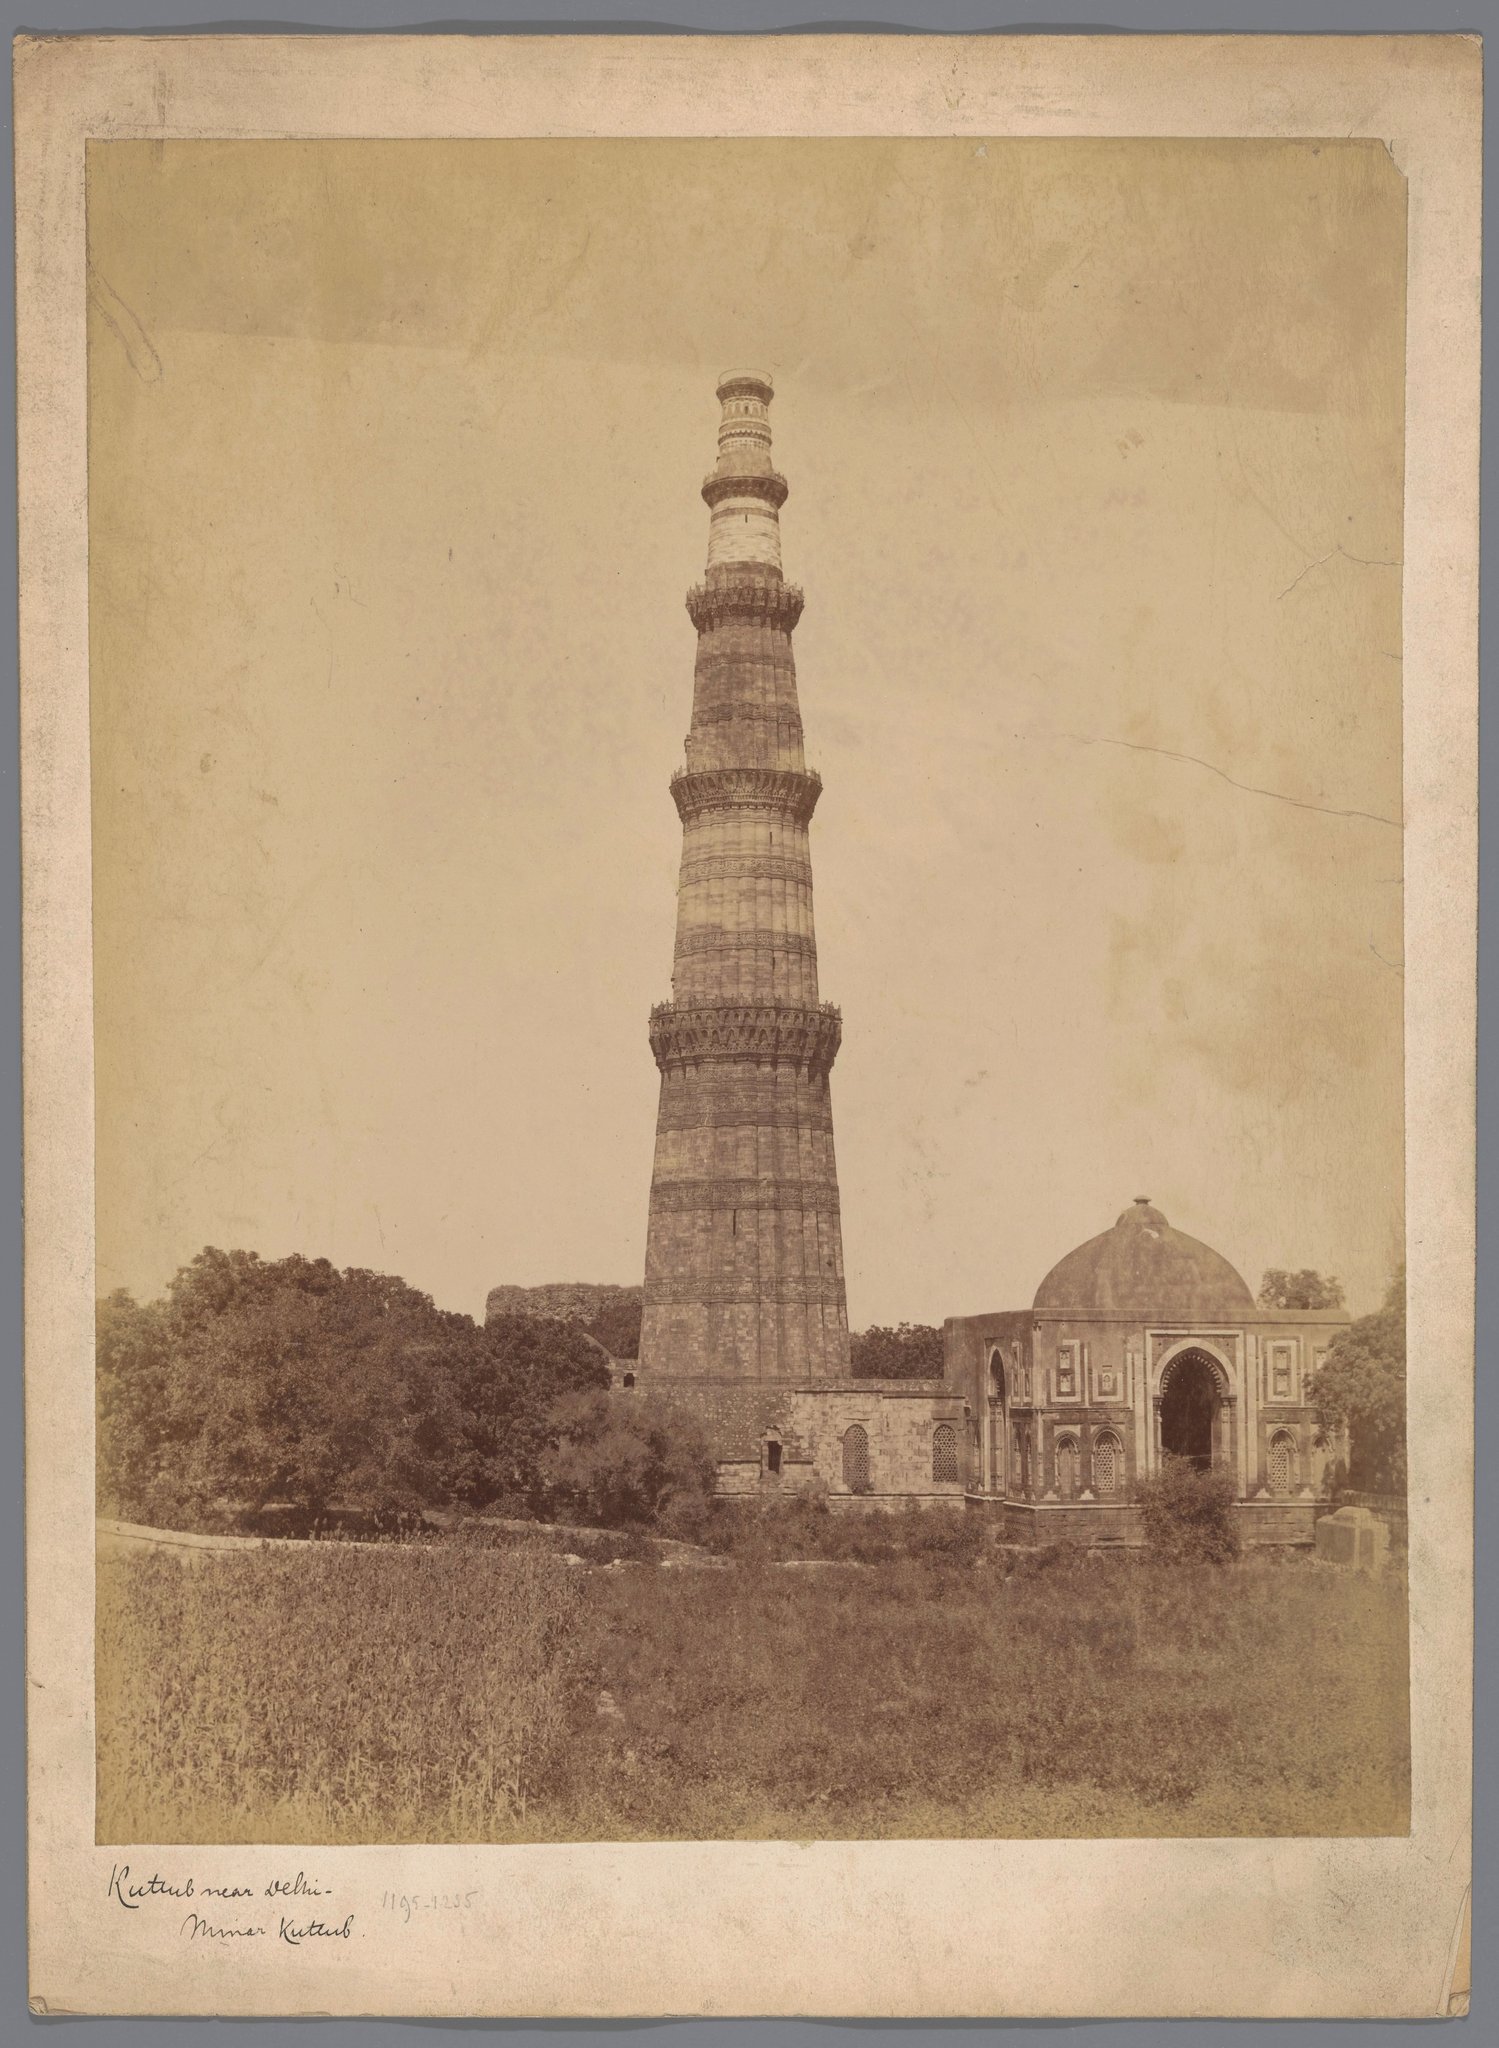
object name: photograph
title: Qutb Minar and Alai Darwaza at the Qutb complex in Delhi, India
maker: Anonymous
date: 1865-1890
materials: cardboard, paper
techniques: albumen print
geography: delhi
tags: tower, clock tower ~ monumental adornment, temple, shrine ~ islam, mohammedanism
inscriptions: title: ‘Kutub near Delhi -/ Minar Kuttub.’, number: ‘1195-1235’, number: ‘33’